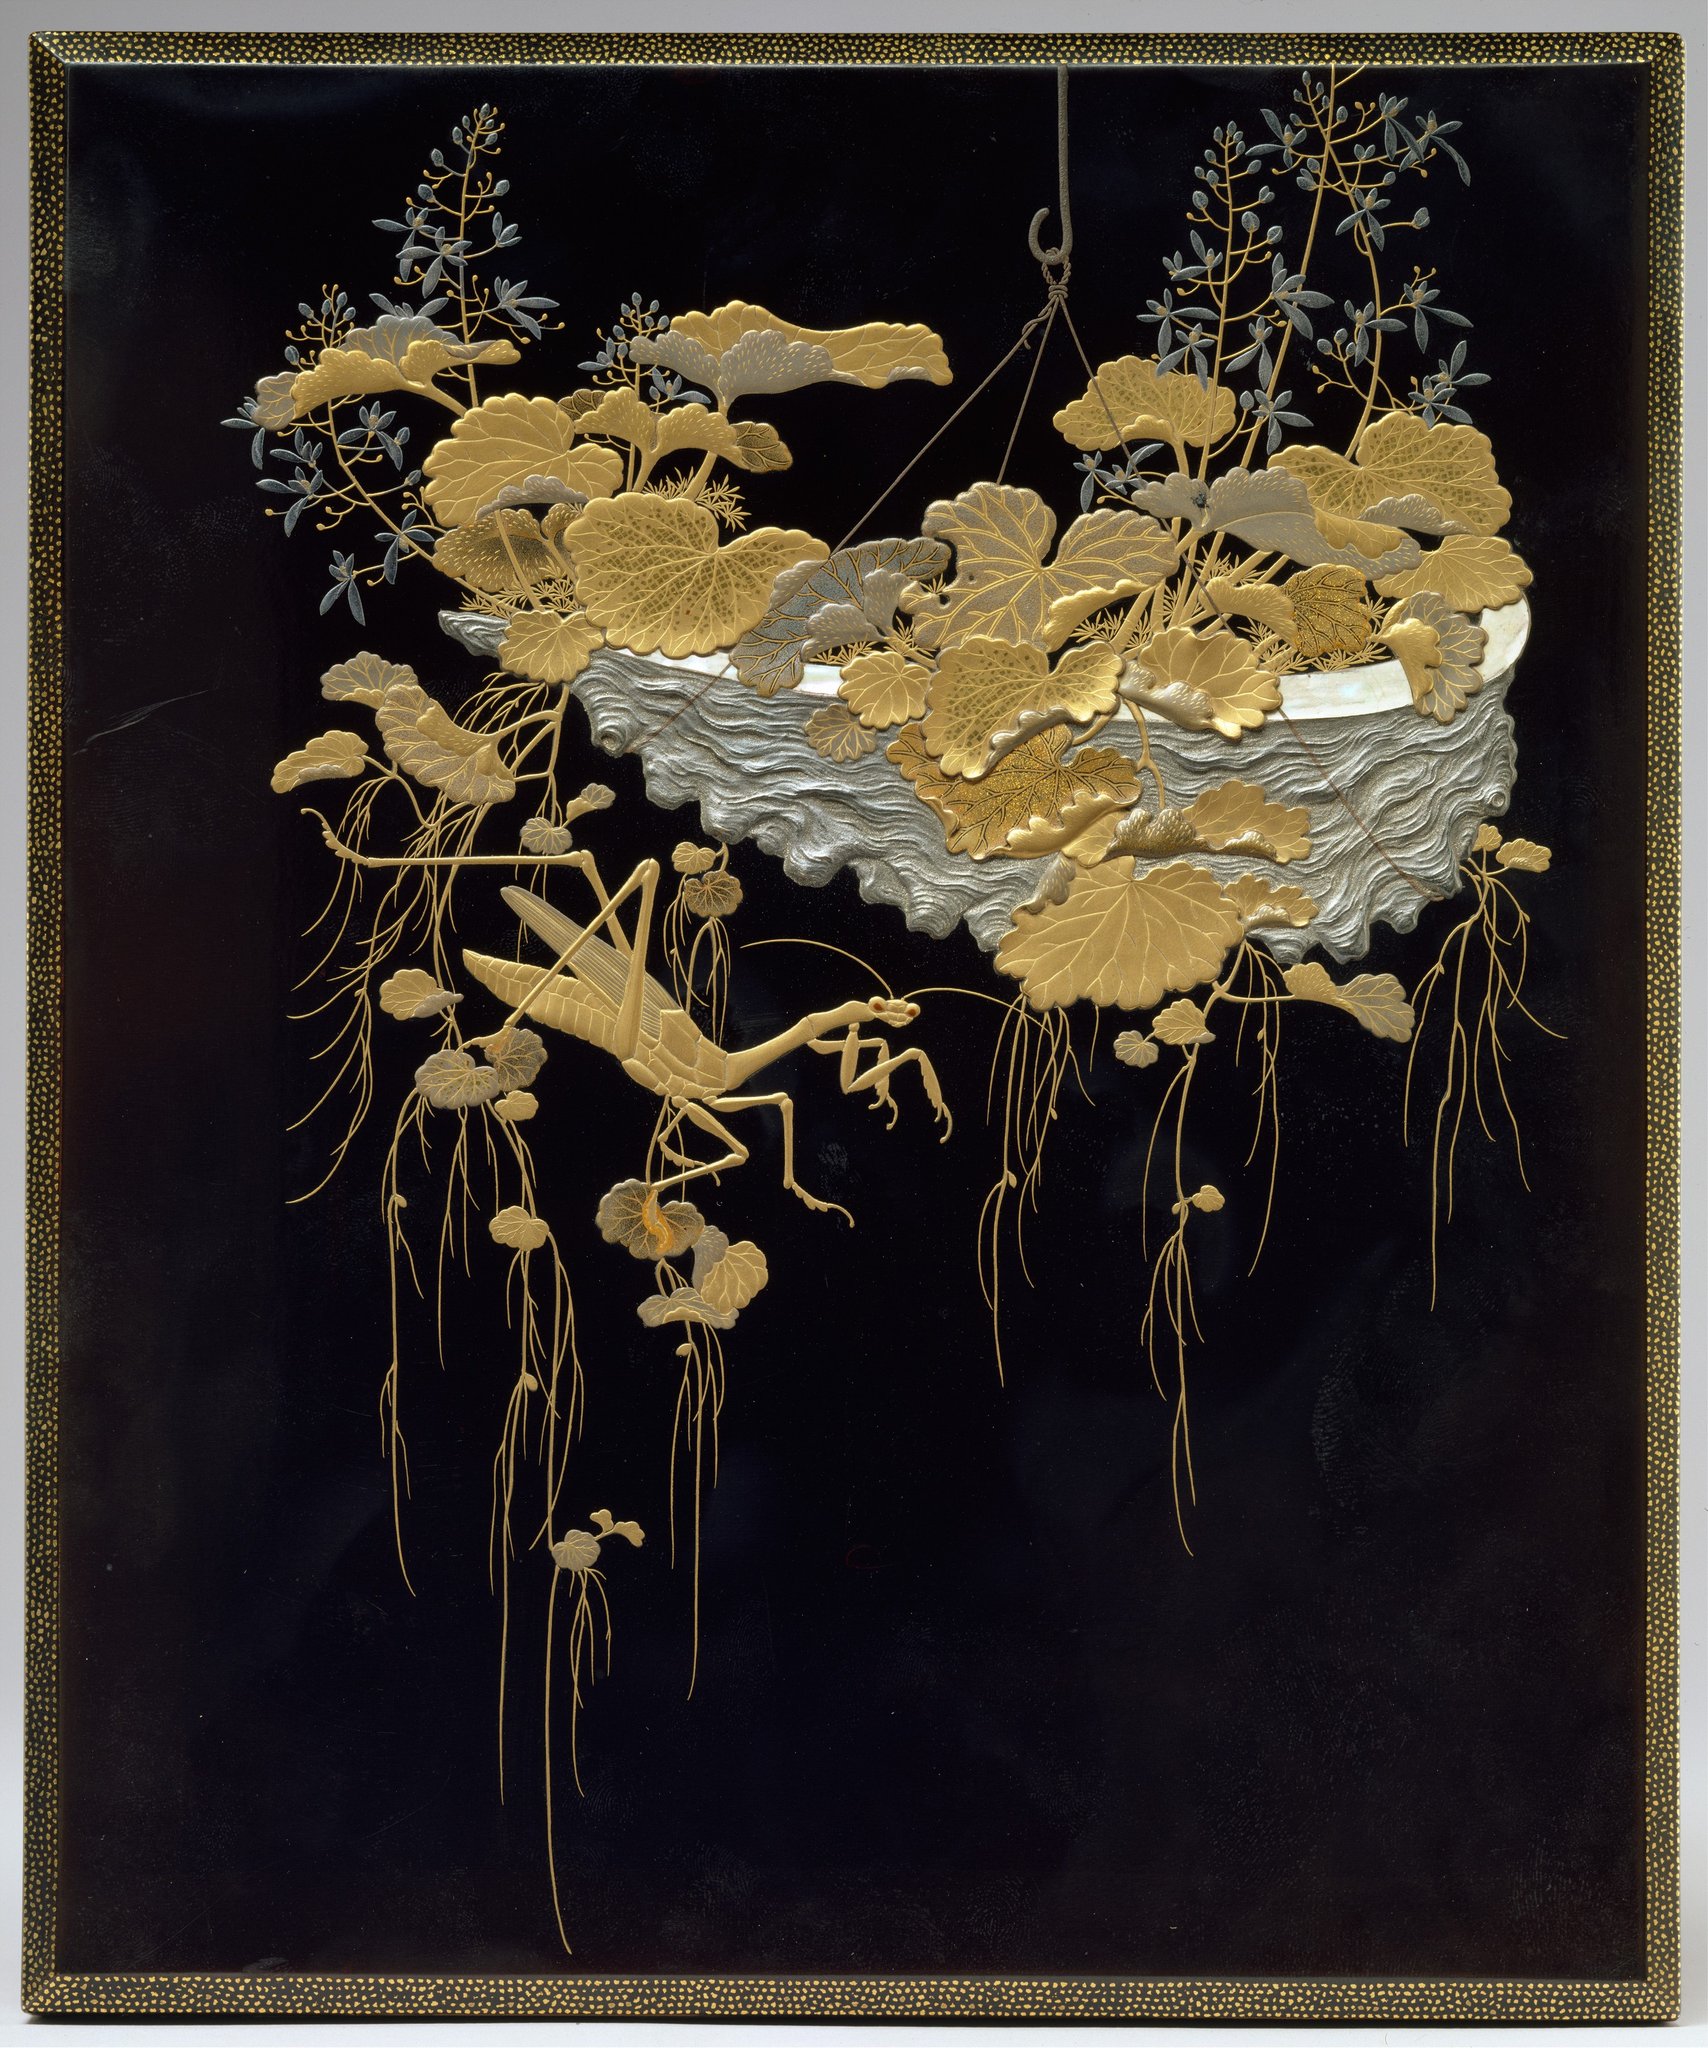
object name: writing box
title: Shikishi (square calligraphy paper) Box with Design of Flowers and Praying Mantis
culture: japanese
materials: gold, gold foil, lacquer, mother of pearl, silver, wood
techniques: hiramakie, inlay, lacquer, maki-e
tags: insects,leaves